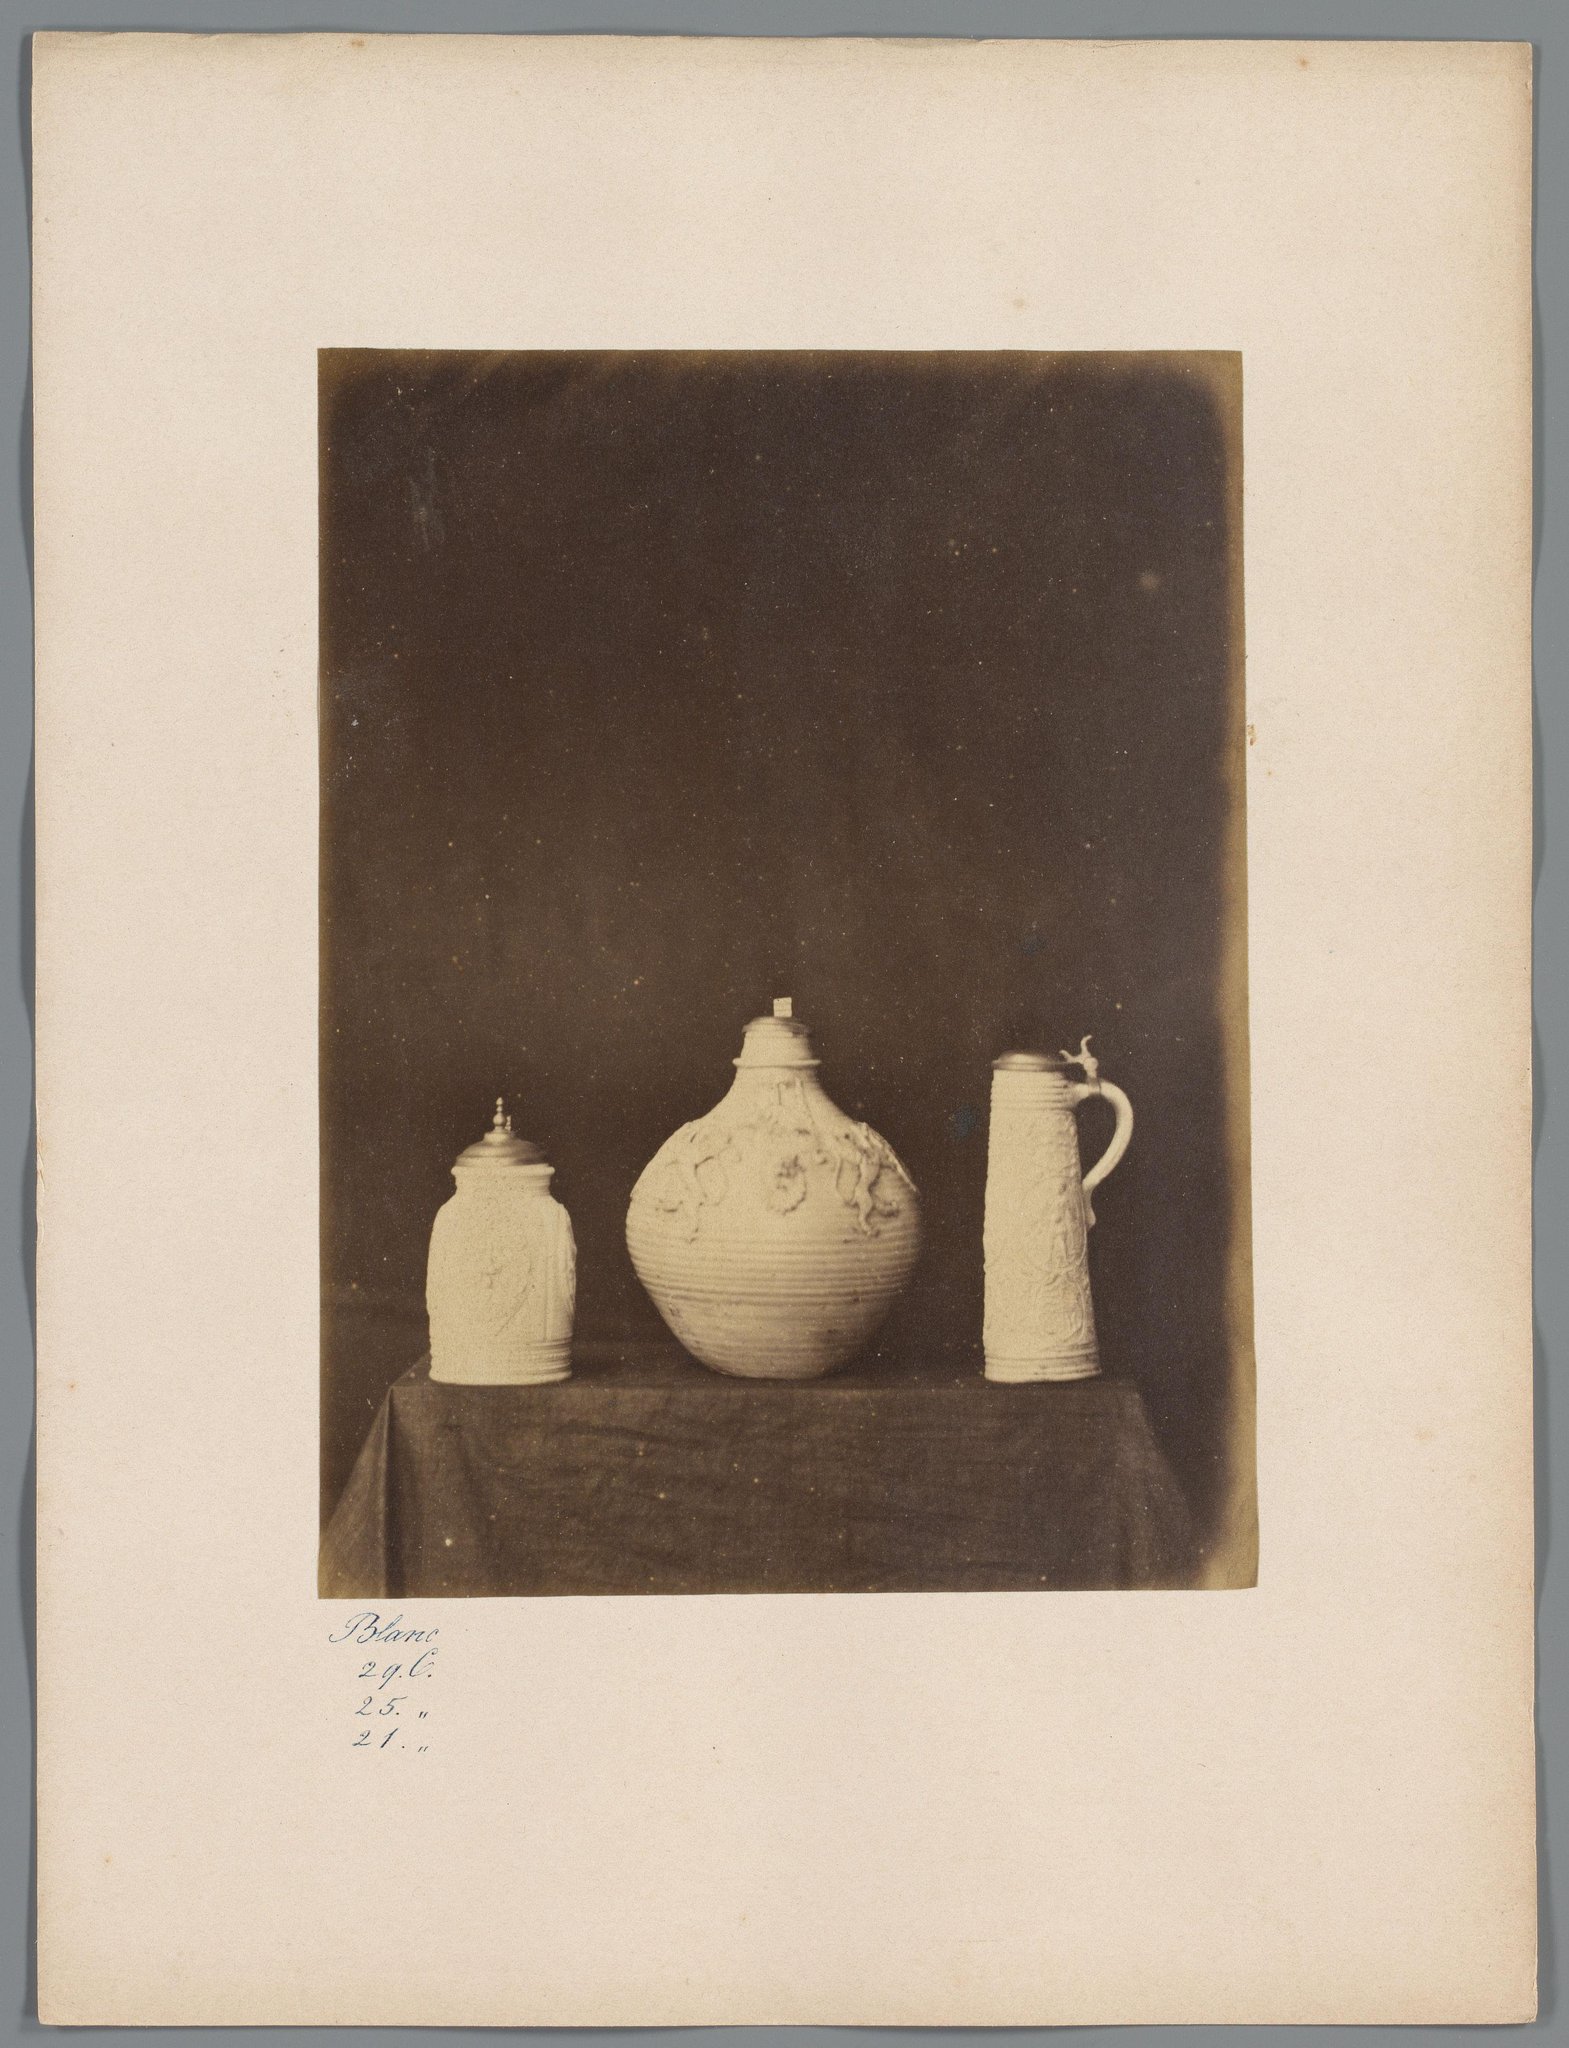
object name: photograph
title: Drie aardewerken vazen, waarvan één met een oor, uit de collectie van W. de Weckherlin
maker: Anonymous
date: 1860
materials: paper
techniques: albumen print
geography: the hague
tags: container of ceramics: jar, jug, pot, vase, the hague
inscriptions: inscription: ‘Blanc/ 29 C./ 25. C./ 21. C.’